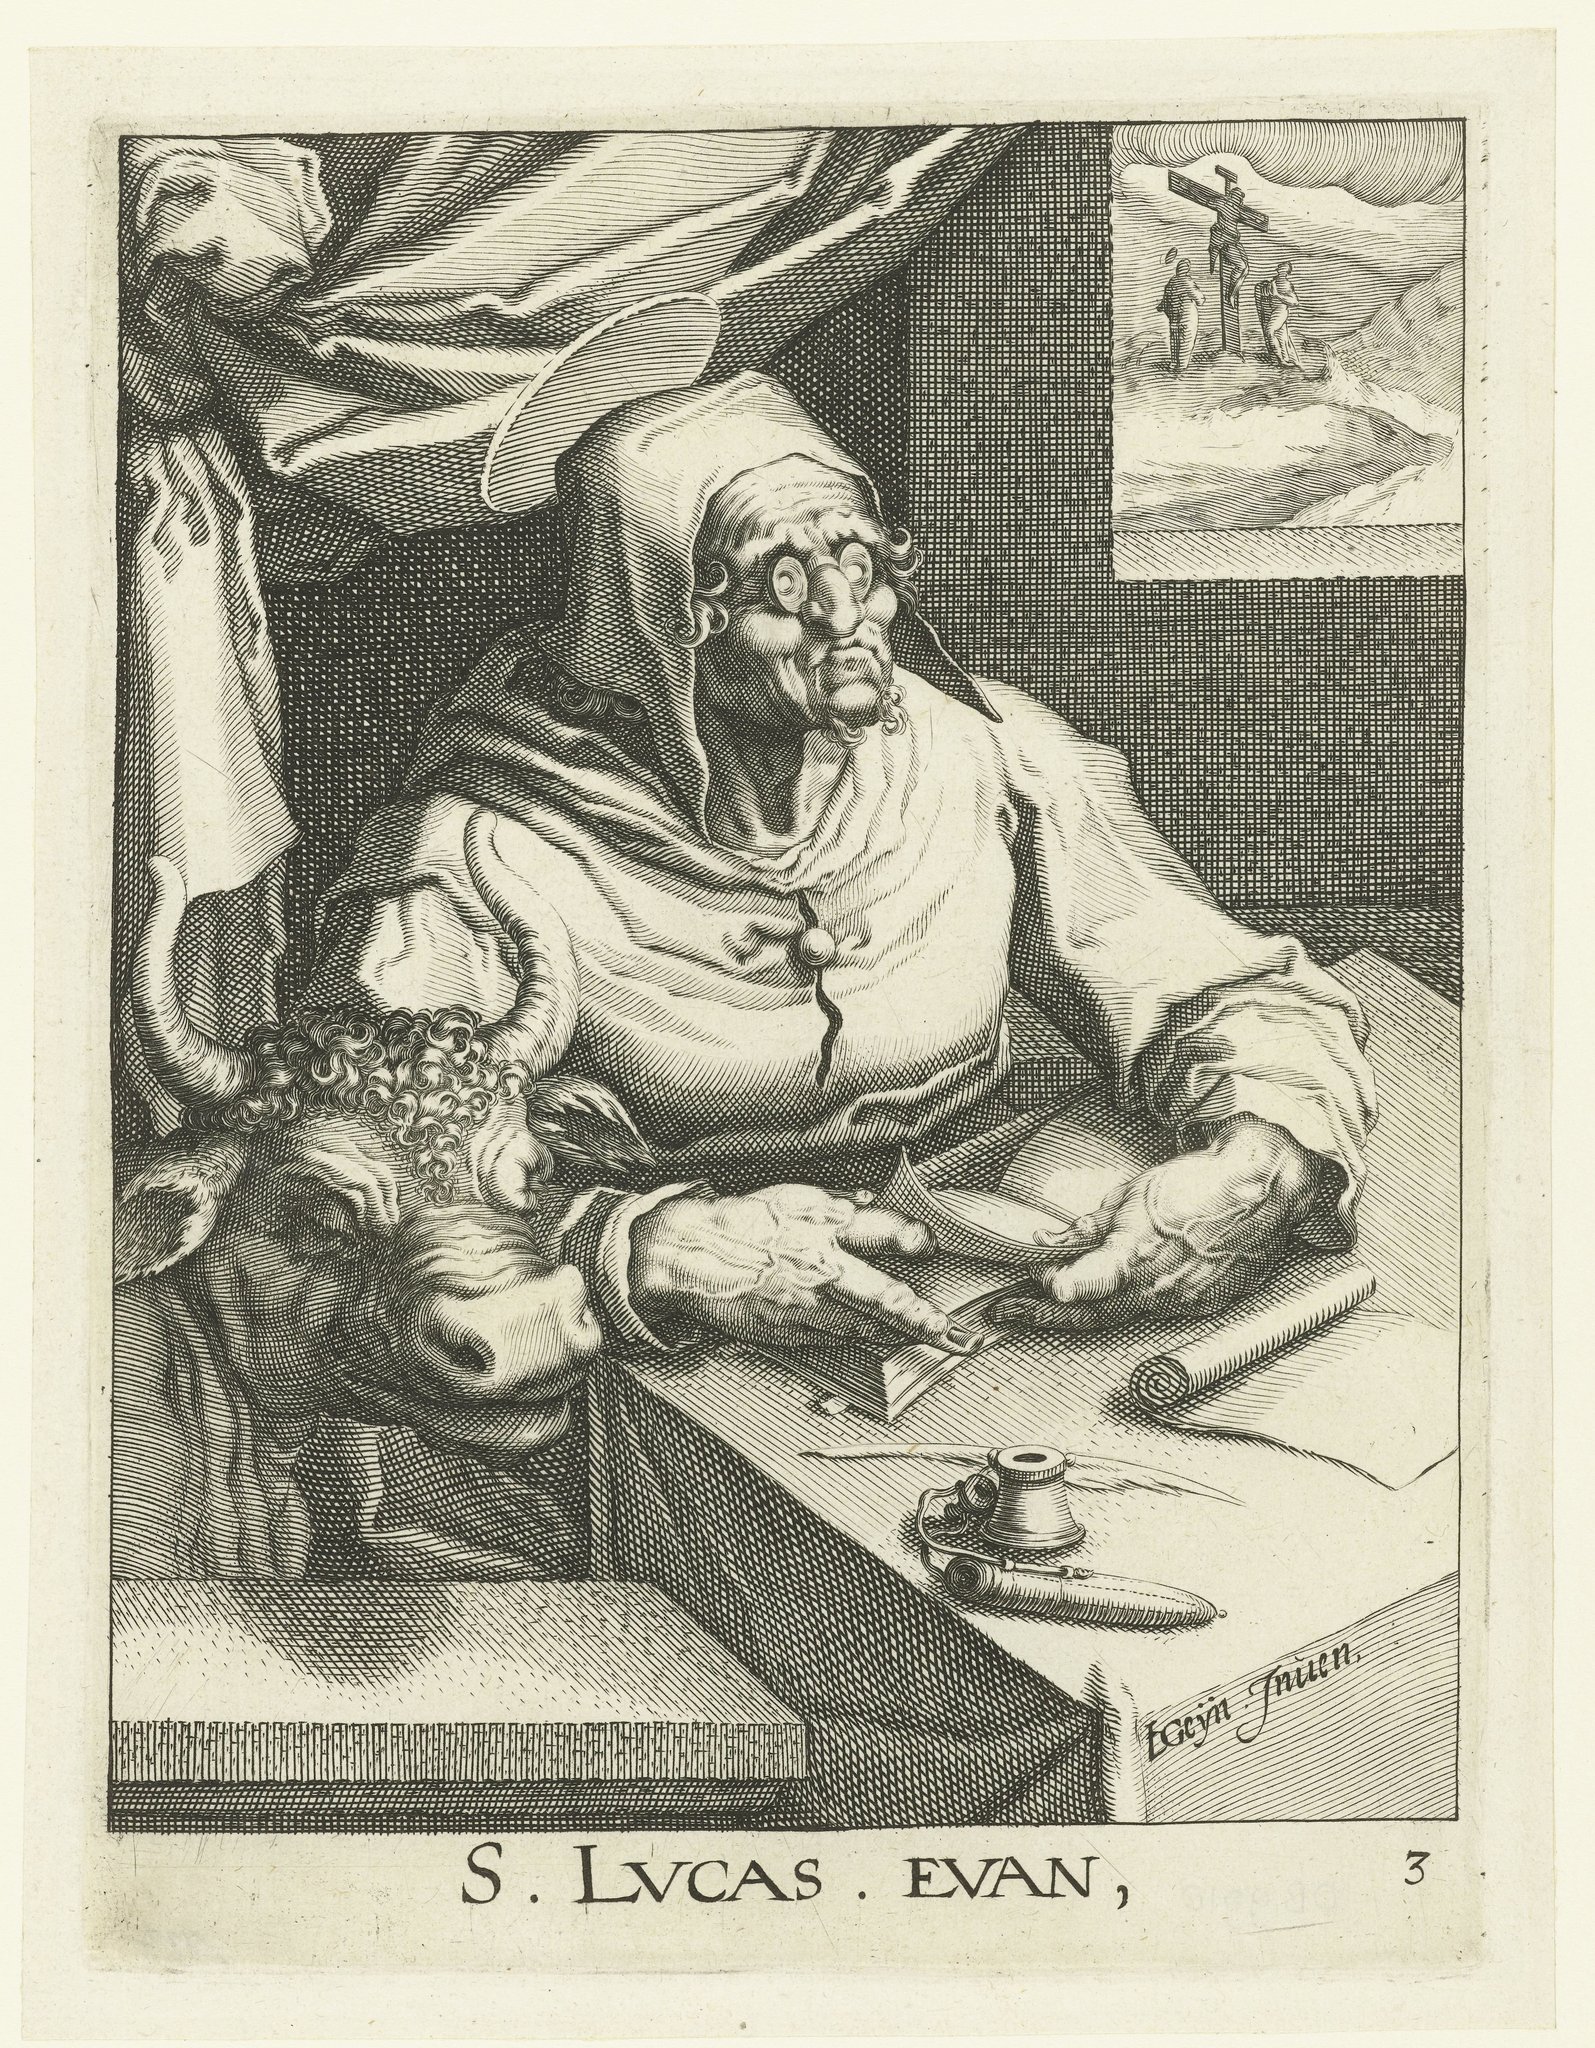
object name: print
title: Evangelist Lucas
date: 1593-1597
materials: paper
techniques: engraving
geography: amsterdam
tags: luke the evangelist; possible attributes: book, (winged) ox, portrait of the virgin, surgical instruments, painter's utensils, scroll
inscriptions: collector's mark: Lugt 2228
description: Lucas de evangelist, gezeten, een boek in de handen. Een rund staat bij zijn rechterzijde. Onder de voorstelling de tekst 'S. Lvcas. evan,'. Deze prent is onderdeel van een serie van vier voorstellingen van de evangelisten, elk met de naam van de betreffende evangelist als onderschrift.